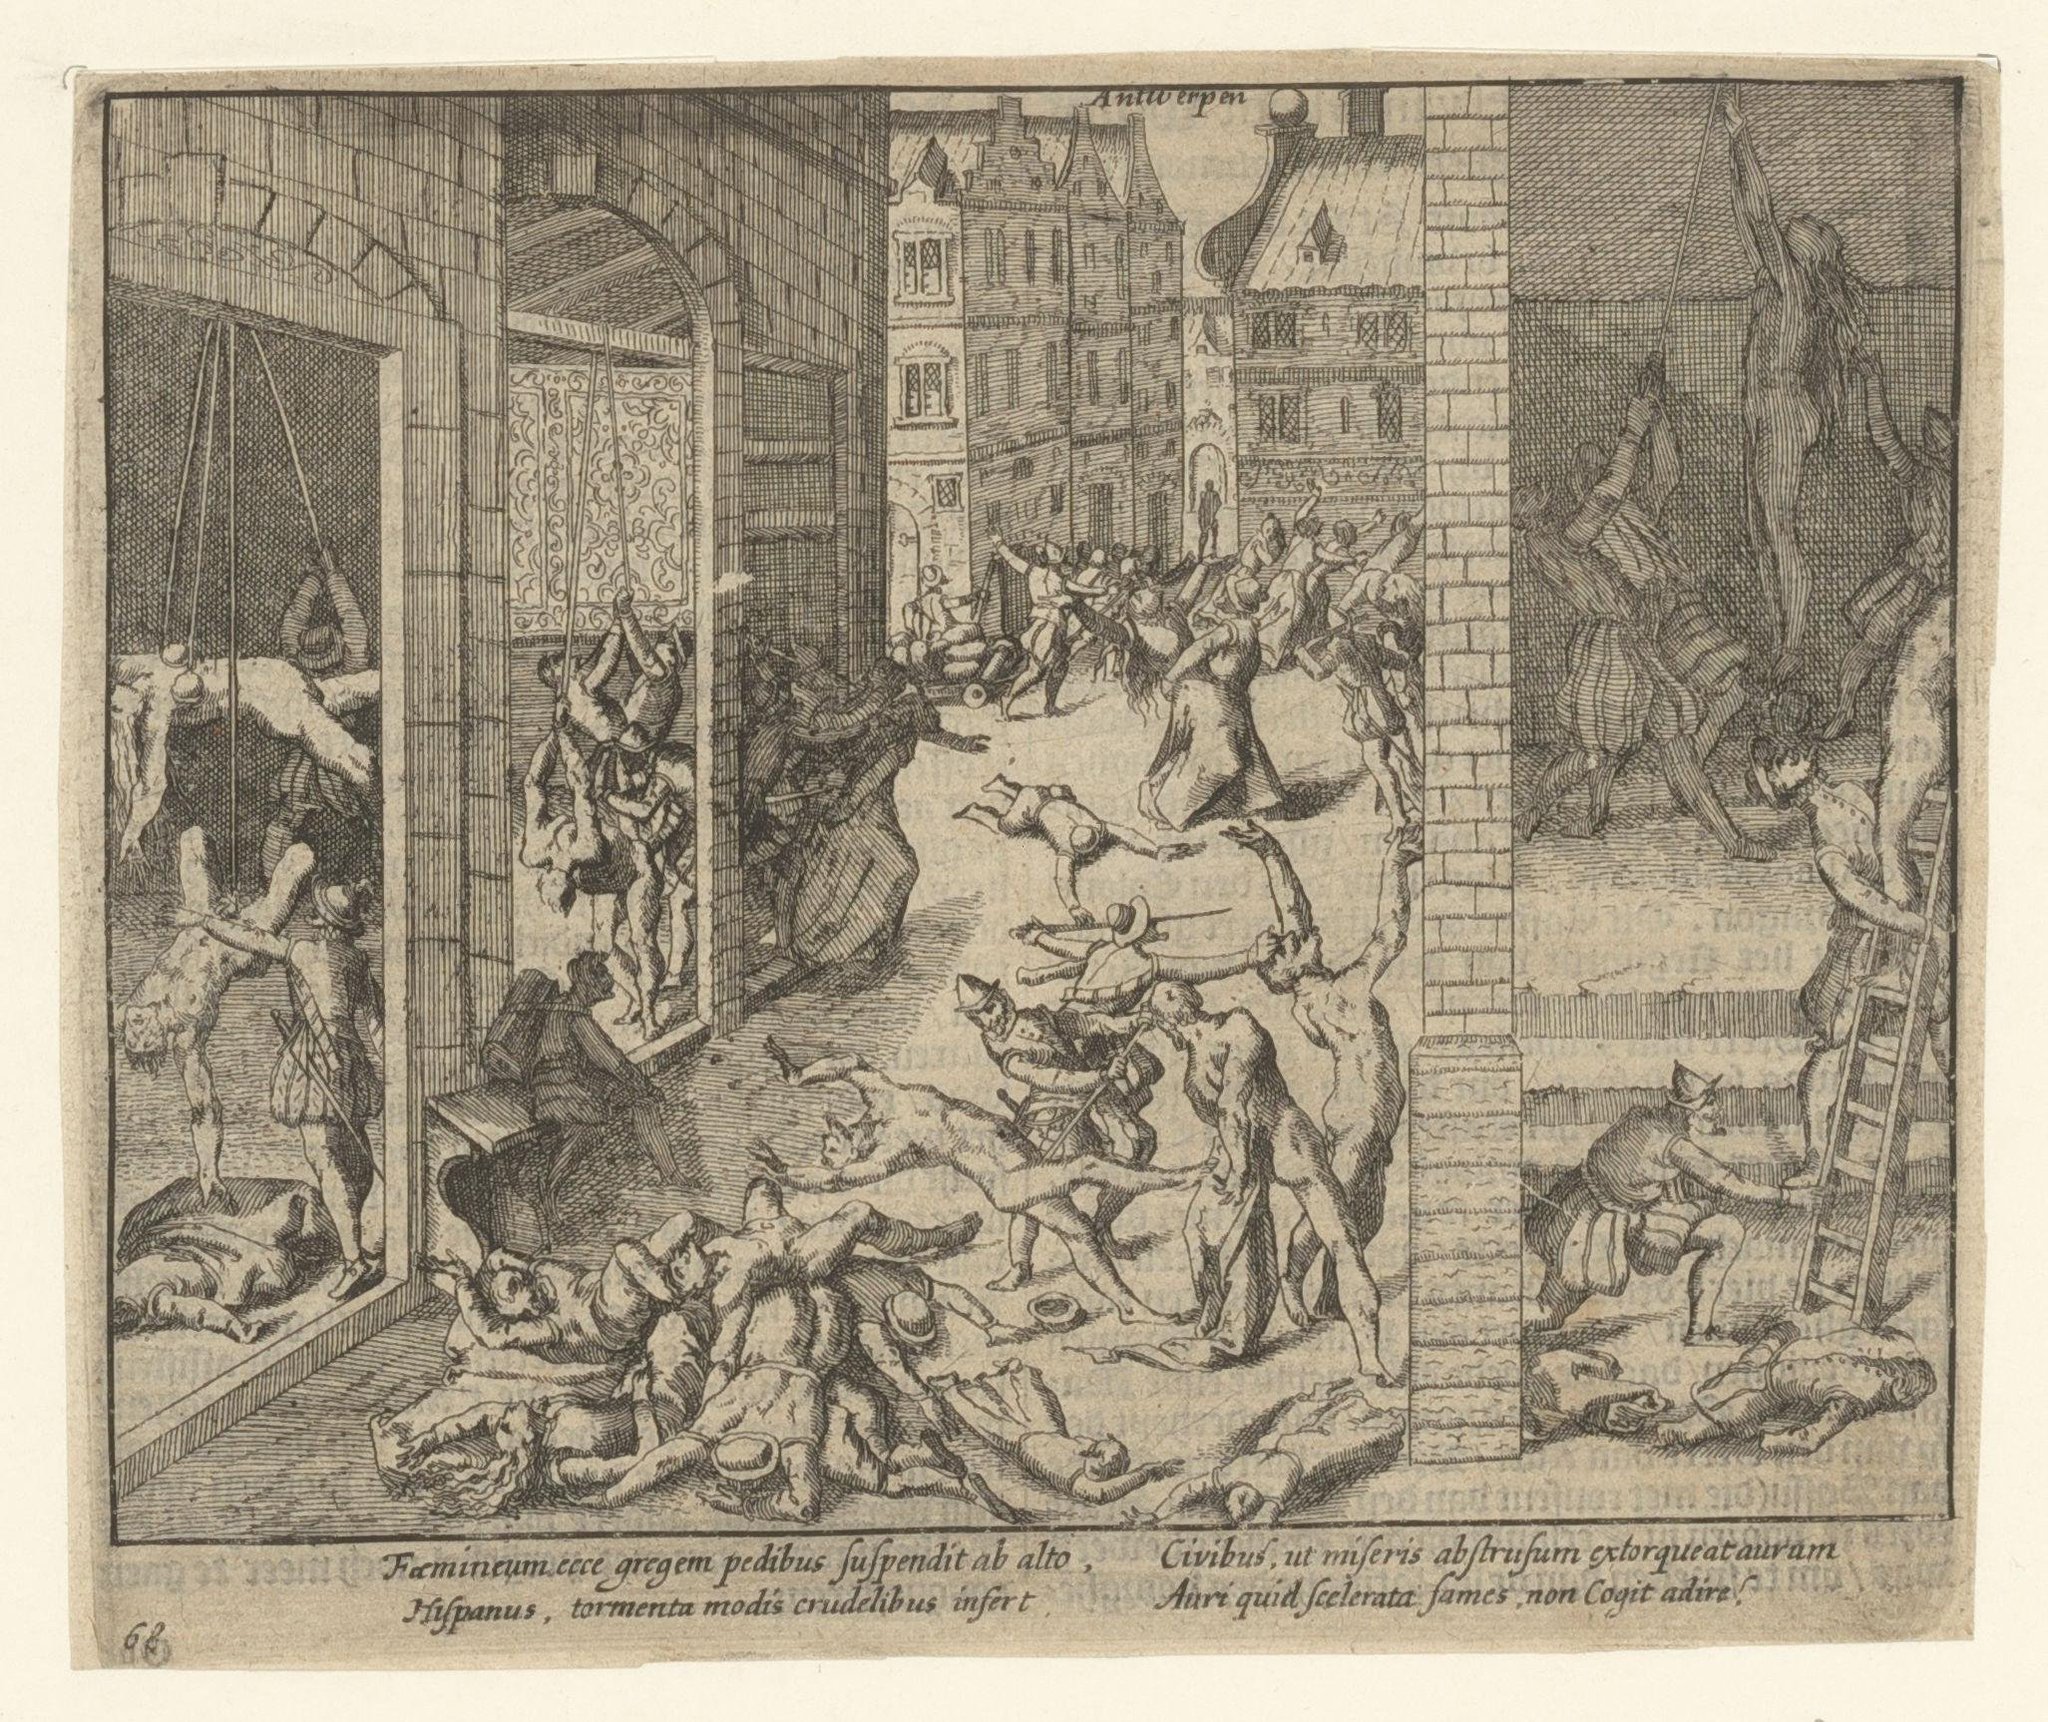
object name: history print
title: Spaanse Furie: gruwelijkheden door de soldaten, 1576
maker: Anonymous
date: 1613-1615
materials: paper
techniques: etching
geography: northern netherlands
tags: torture, massacre ~ war, antwerp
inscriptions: collector's mark: Lugt 1641, collector's mark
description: Deze platen genomen uit: W. Baudartius, De Nassausche oorloghen. Afbeeldinghe, ende beschrijvinghe van alle de veldslagen, belegeringen, ende and're notable geschiedenissen, ghevallen in de Nederlanden, geduerende d'oorloghe teghens de Coningh van Spaengien, onder het beleydt van den Prince van Oraengien, ende Prince Maurits de Nassau, etc. Amsterdam: Michiel Colijn, 1615.